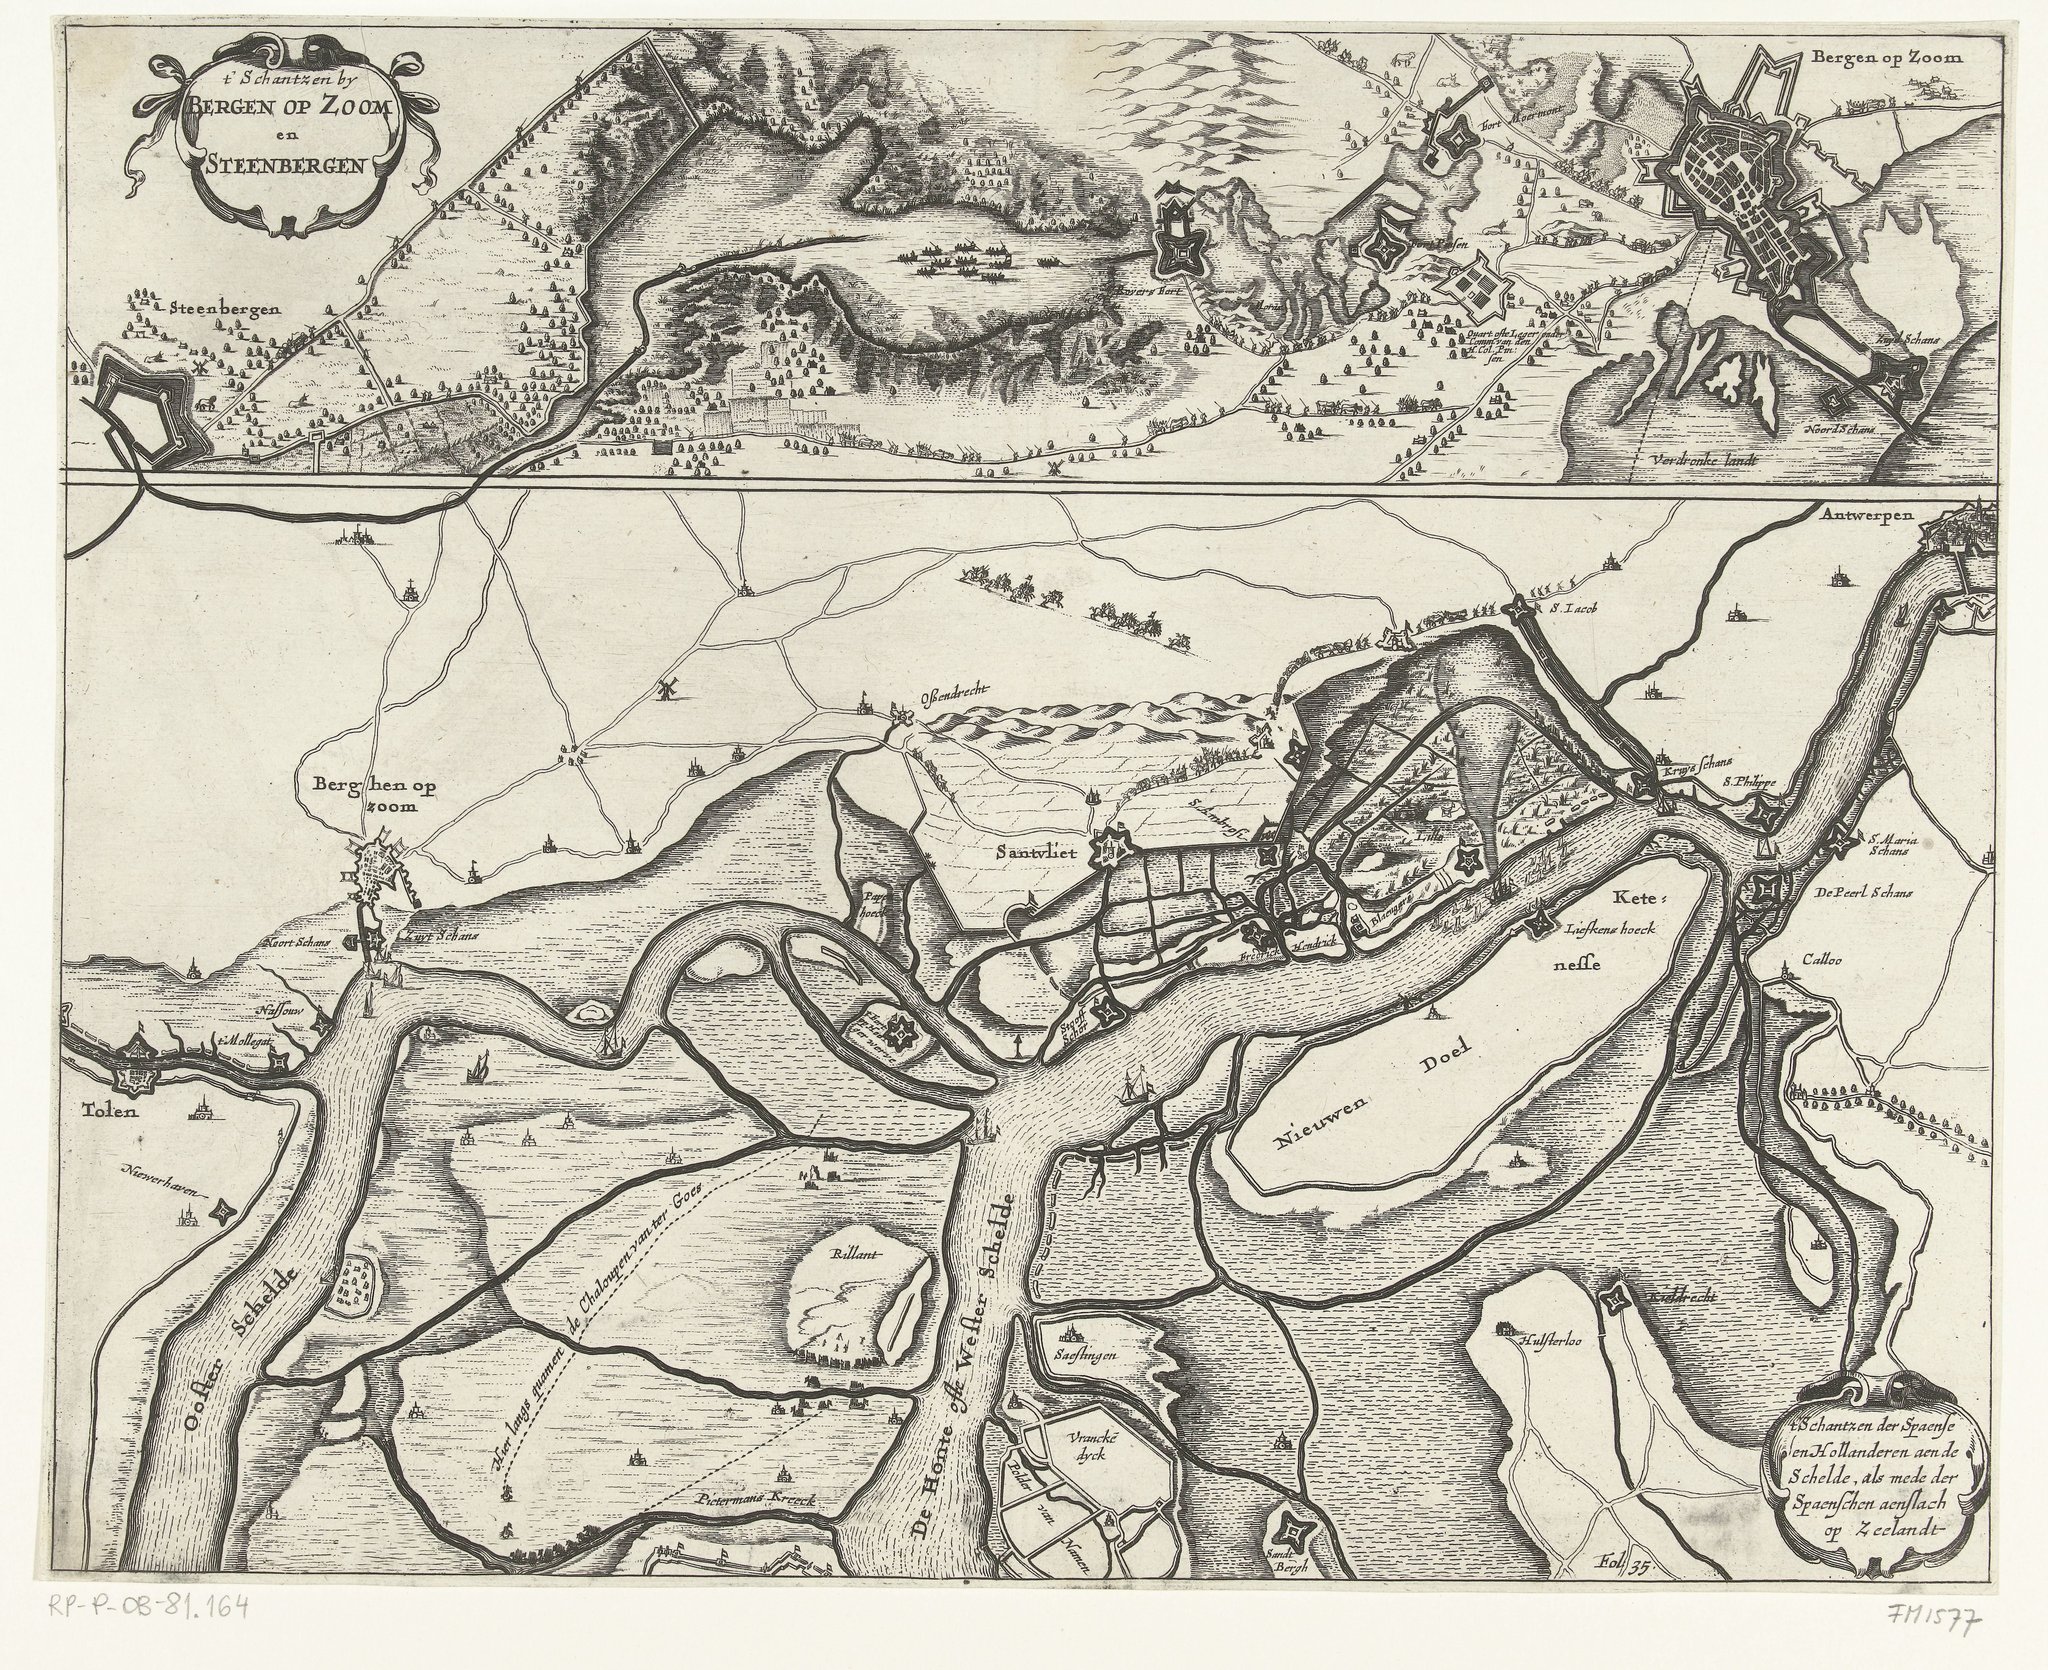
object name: history print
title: 't Schantzen by Bergen op Zoom en Steenbergen / 't Schantzen der Spaense en Hollanderen aen de Schelde, als mede der Spaenschen aenslach op Zeelandt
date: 1649-1651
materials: paper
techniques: etching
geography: northern netherlands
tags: maps of separate countries or regions, bergen op zoom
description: Blad met twee voorstellingen. Boven de schansen bij het mislukte beleg van Bergen op Zoom door het Spaanse leger onder Spinola en Velasco, 18 juli - 3 oktober 1622. Onder een kaart van het rivieren- en krekengebied tussen de Ooster- en Westerschelde met de bouw van Hollandse en Spaanse schansen aan de Schelde in 1627, waaronder de Spaanse schans bij Zandvliet. Met de aanslag van Spinola op Zuid-Beveland, september 1627. Gemerkt rechtsonder Fol. 35.